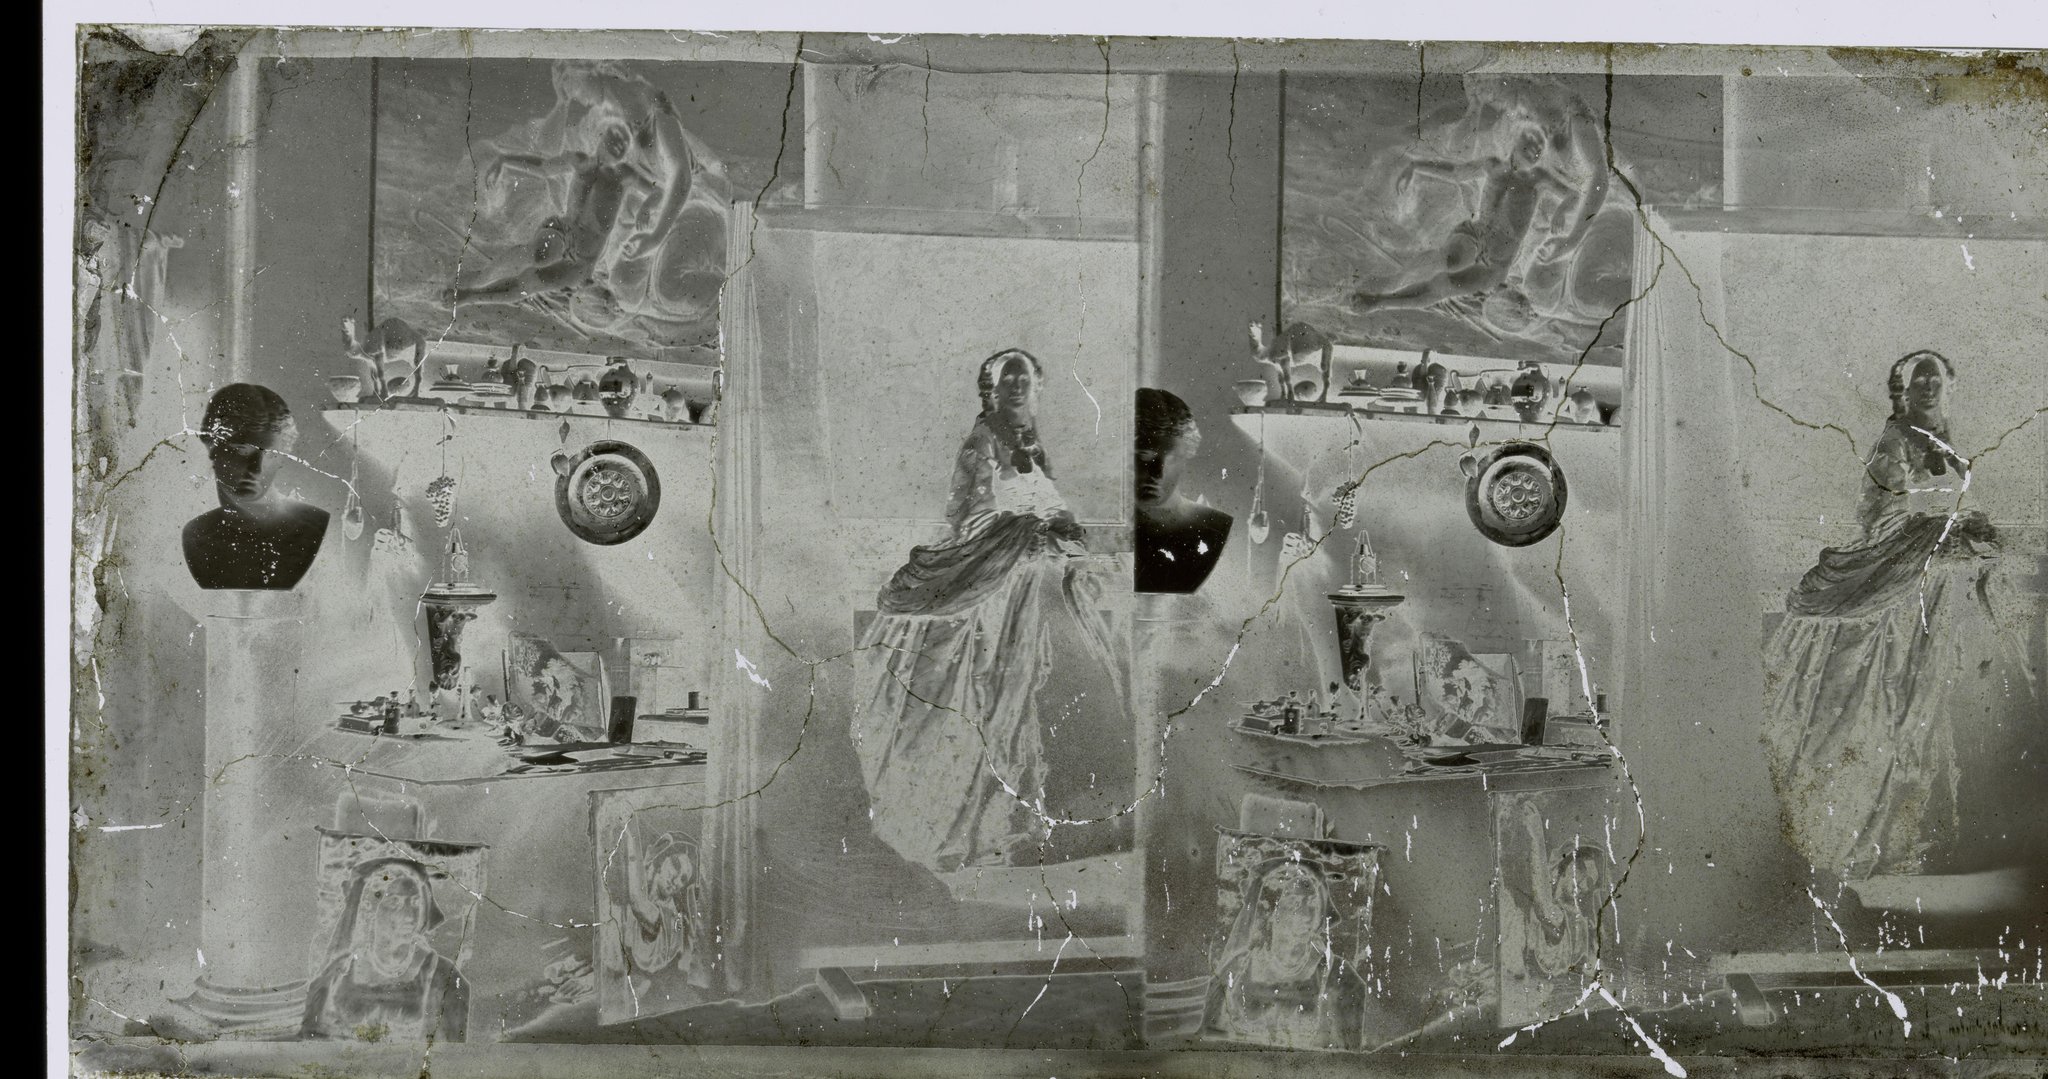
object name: glass negative stereograph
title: Interieur van het atelier van Laurens Lodewijk Kleijn in Rome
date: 1860-1862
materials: glass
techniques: collodion process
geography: rome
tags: workshop, studio of the artist (in general)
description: Onderdeel van een groep glasnegatieven uit de nalatenschap van de schilder Laurens Lodewijk Kleijn, met stillevens, portretten, zelfportretten en kunstreproducties.